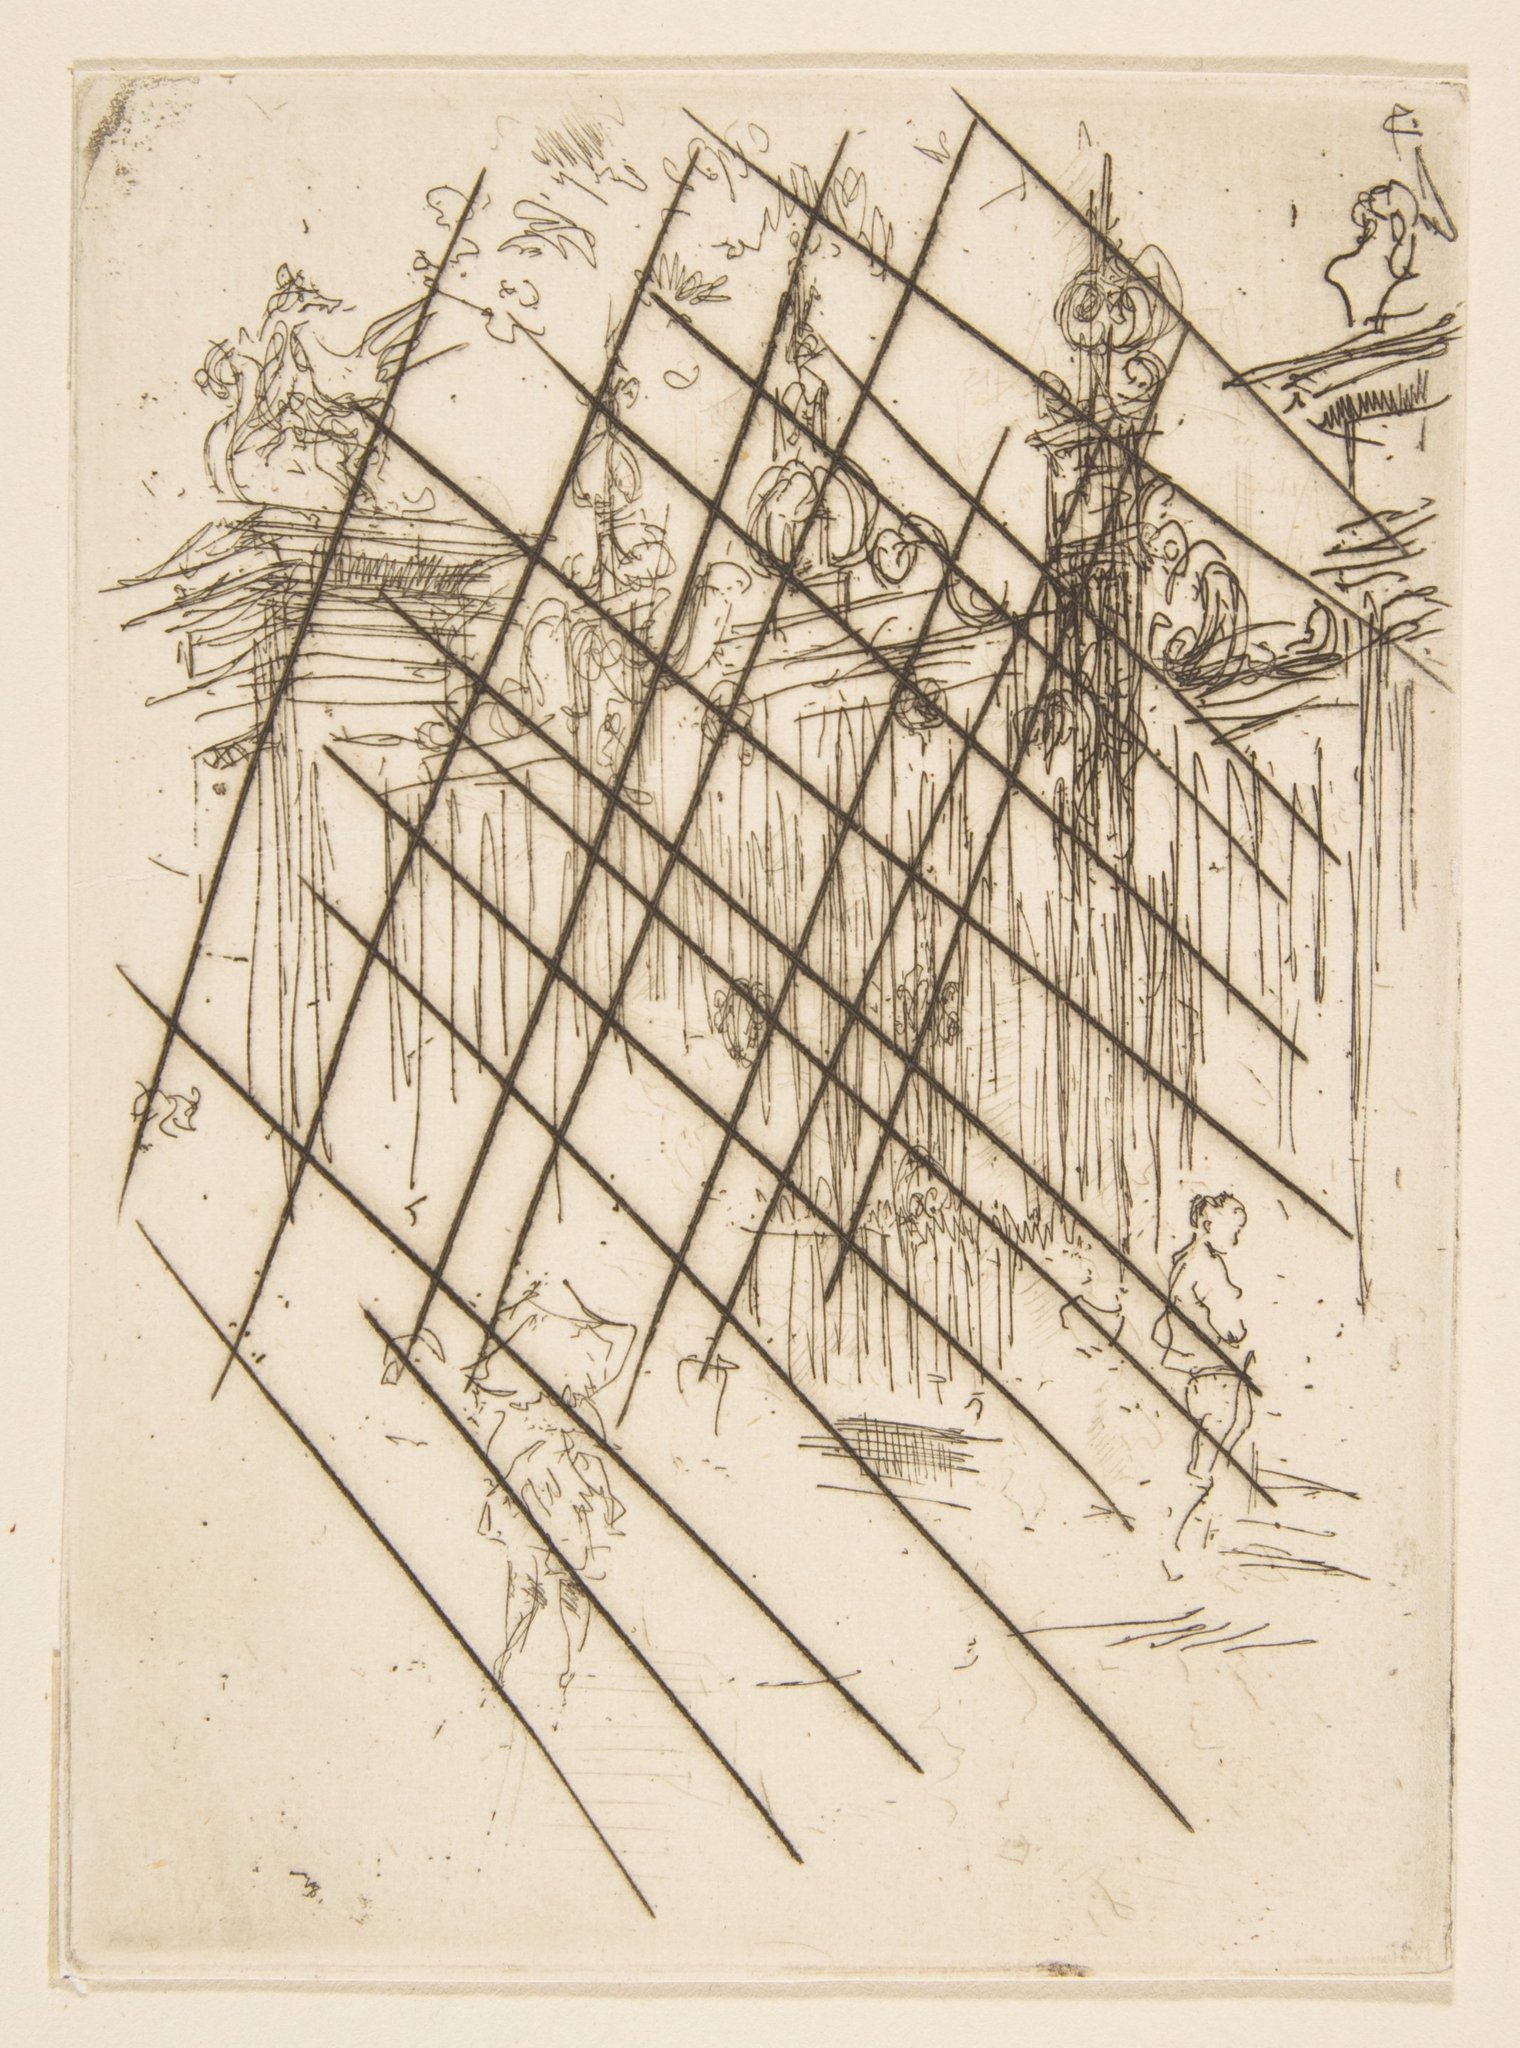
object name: print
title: Gates, City, London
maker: james mcneill whistler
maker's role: artist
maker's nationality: american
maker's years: 1834-1903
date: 1887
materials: ink, paper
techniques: etching, printing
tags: gates,london